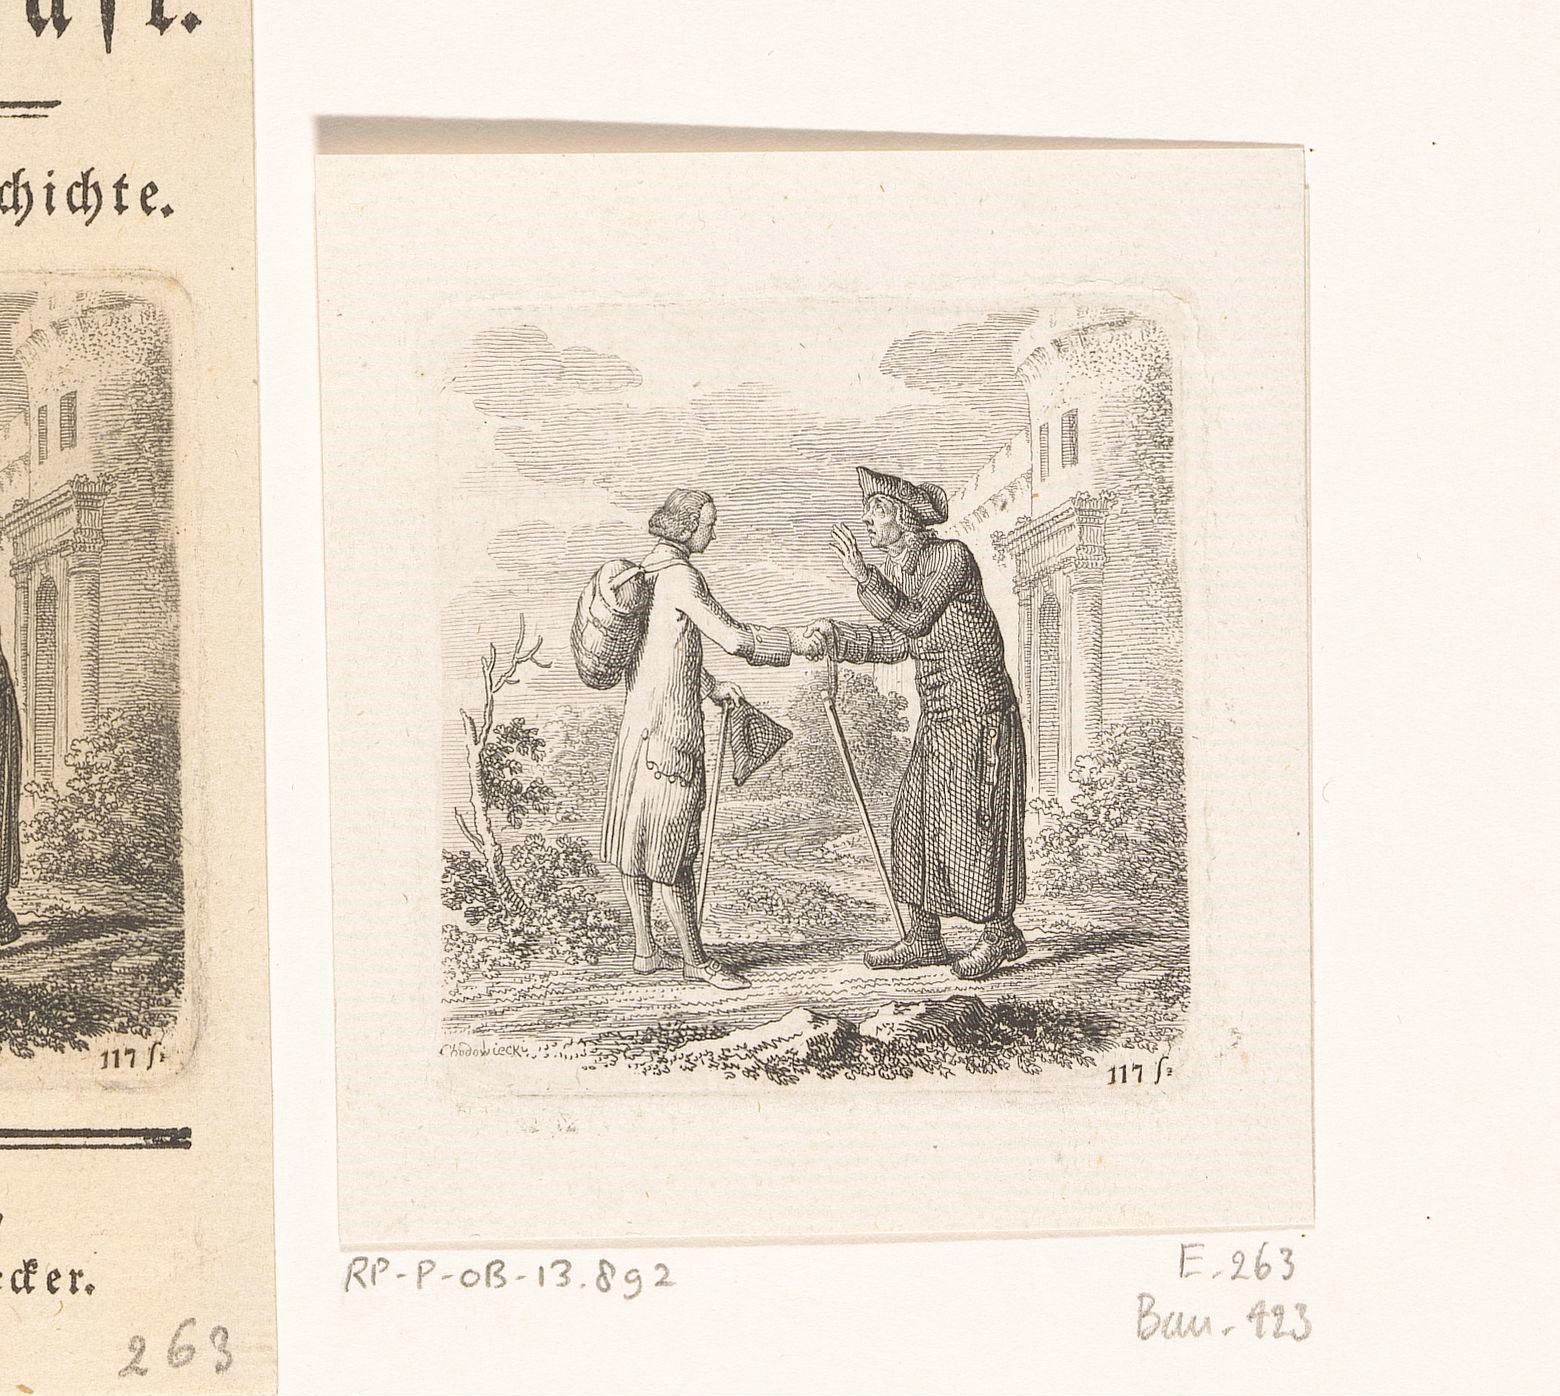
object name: print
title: Henrich Stilling neemt afscheid van Molitor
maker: daniel nikolaus chodowiecki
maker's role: draughtsman, print maker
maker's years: 1726-1801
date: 1778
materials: paper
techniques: etching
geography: berlin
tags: shaking hands, 'dextrarum junctio', literature, departure ~ travelling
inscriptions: collector's mark: Lugt 2228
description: Henrich Stilling schudt de hand van Molitor, een katholieke geestelijke. Van hem heeft hij een manuscript gekregen met aantekeningen op het gebied van de oogheelkunst. Rechtsonder genummerd: 117 S.